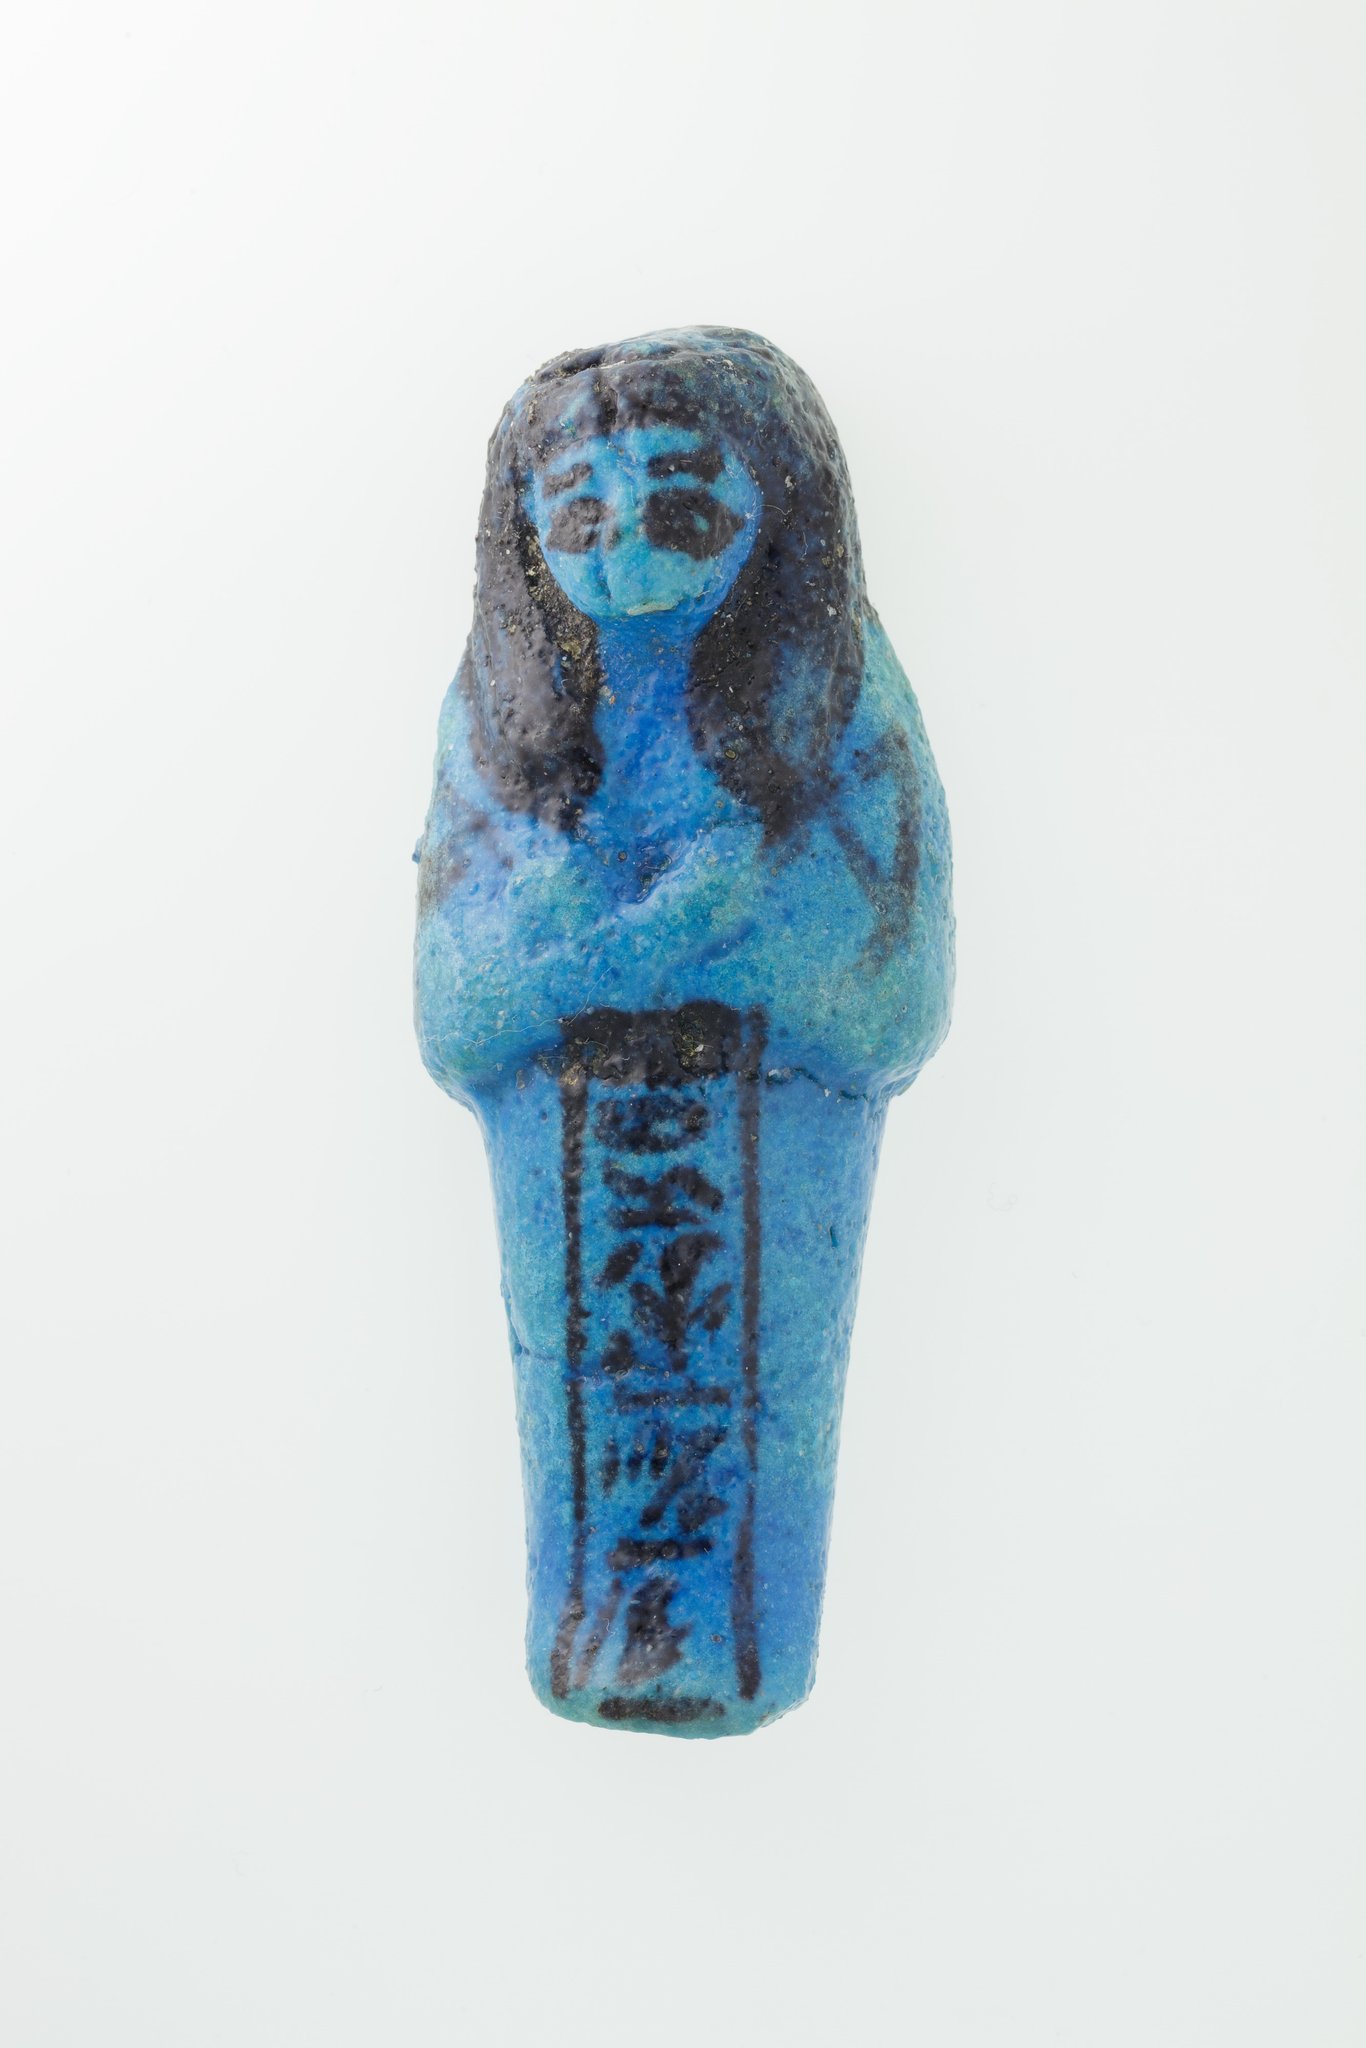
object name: shabti, worker, nauny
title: Worker Shabti of Nauny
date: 1050 BCE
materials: faience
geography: egypt